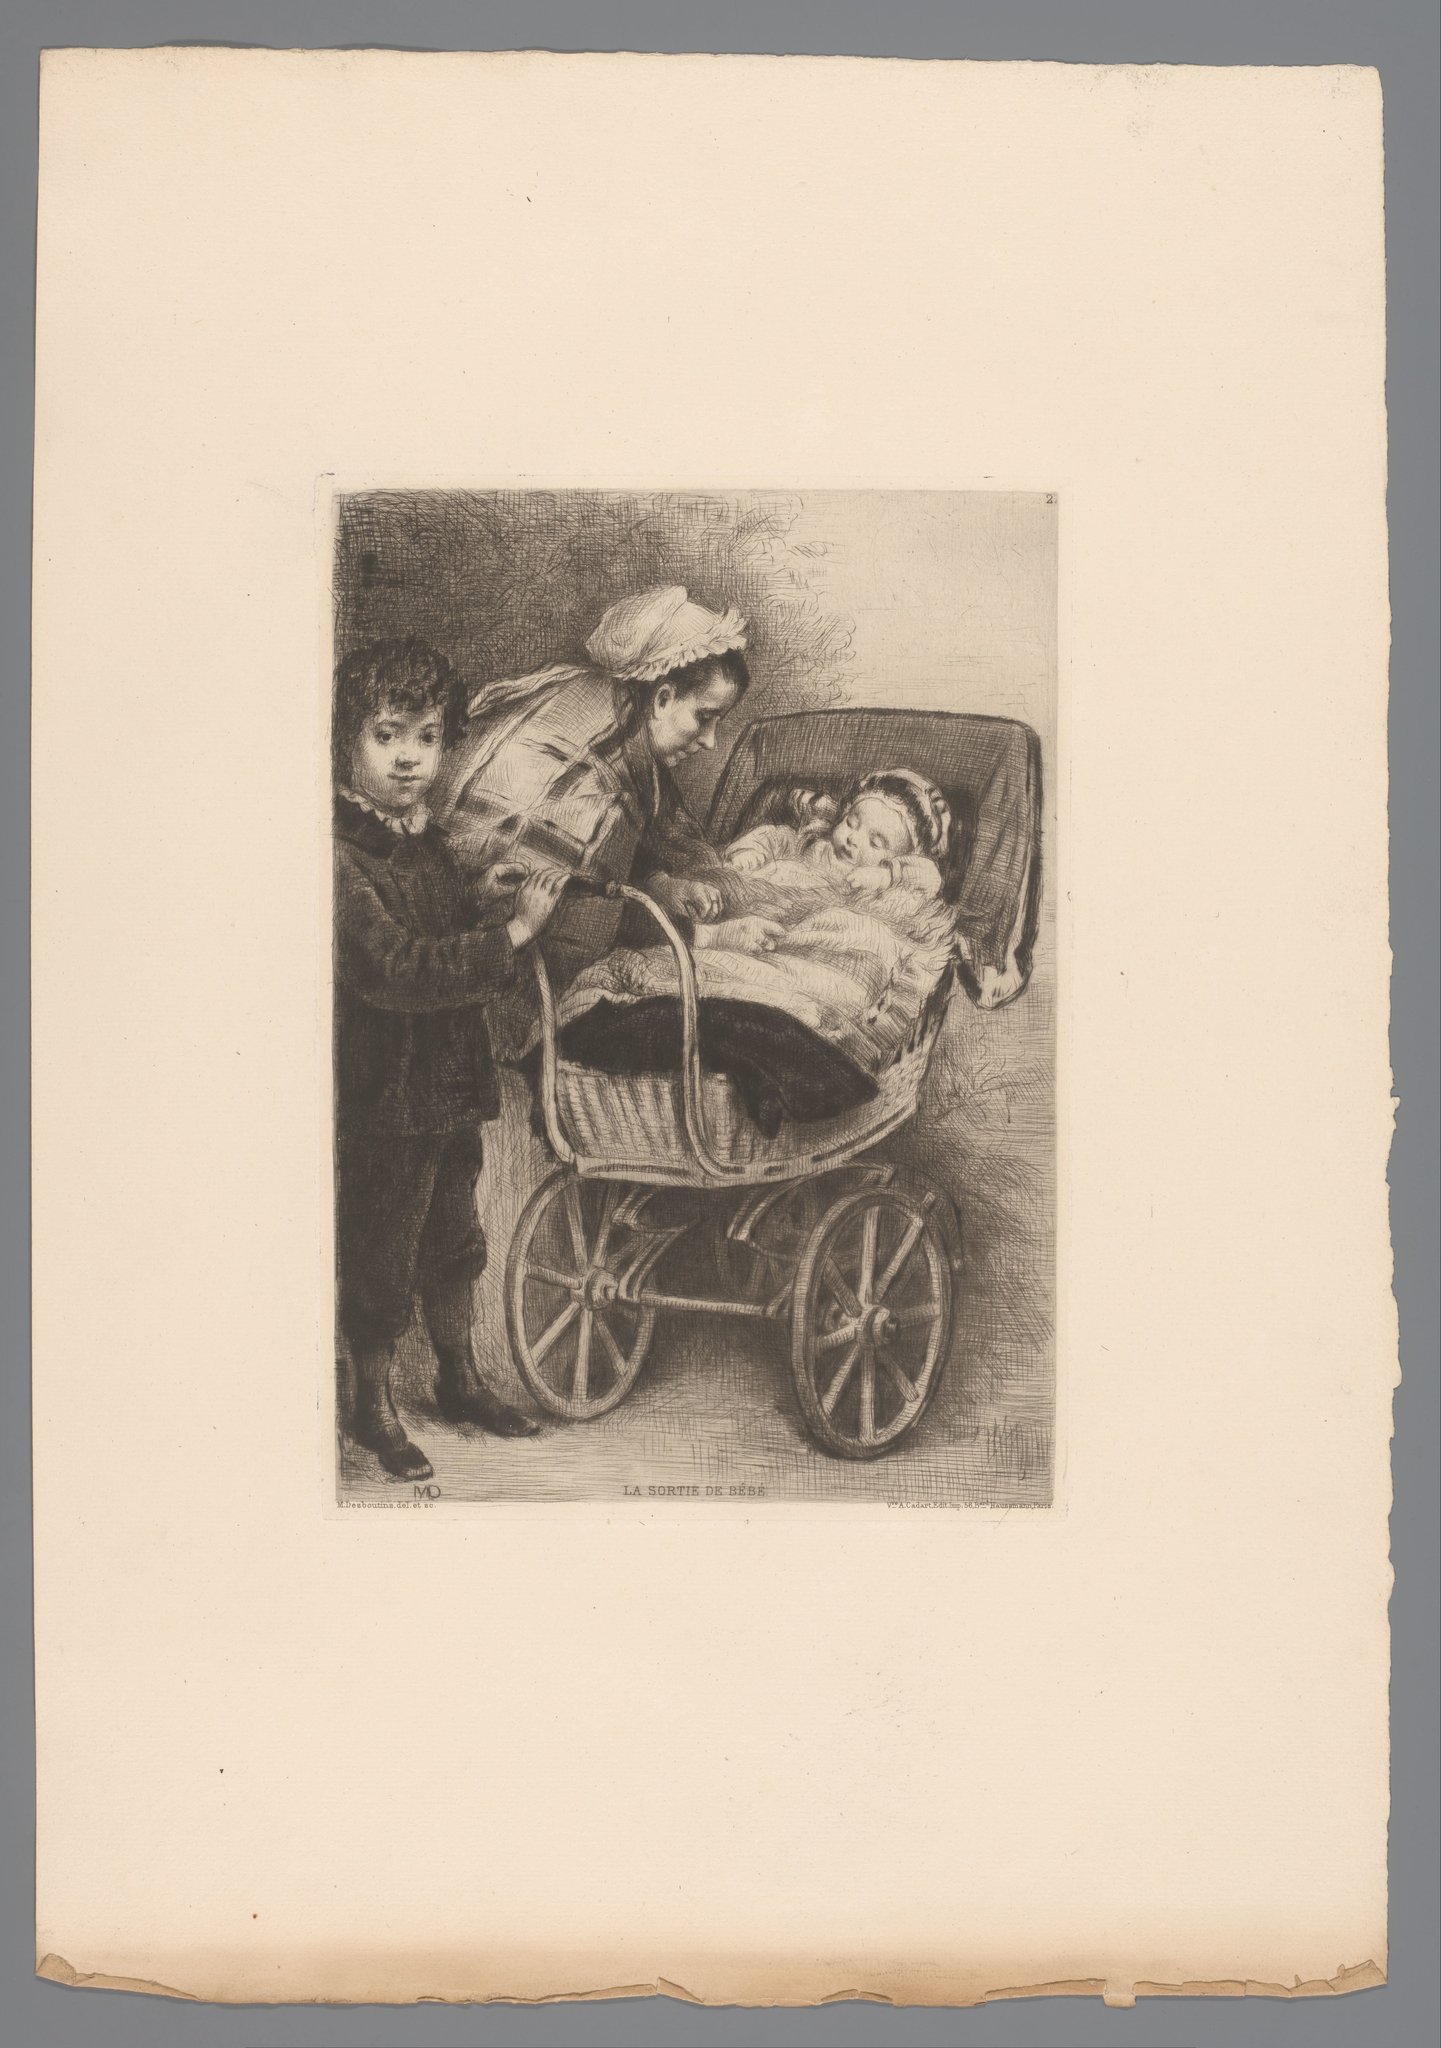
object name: print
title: L'eau-forte en 1879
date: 1879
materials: paper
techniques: drypoint, etching, intaglio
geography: paris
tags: baby-carriage, pram, perambulator, mother and child(ren), woman and child(ren) (family group)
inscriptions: collector's mark: Lugt 2760, collector's mark: Lugt 2228, collector's mark: ‘AFE v S’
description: Het betreft hier waarschijnlijk de vrouw en twee zoons (Andre Mycho en Tchiquine) van de kunstenaar.